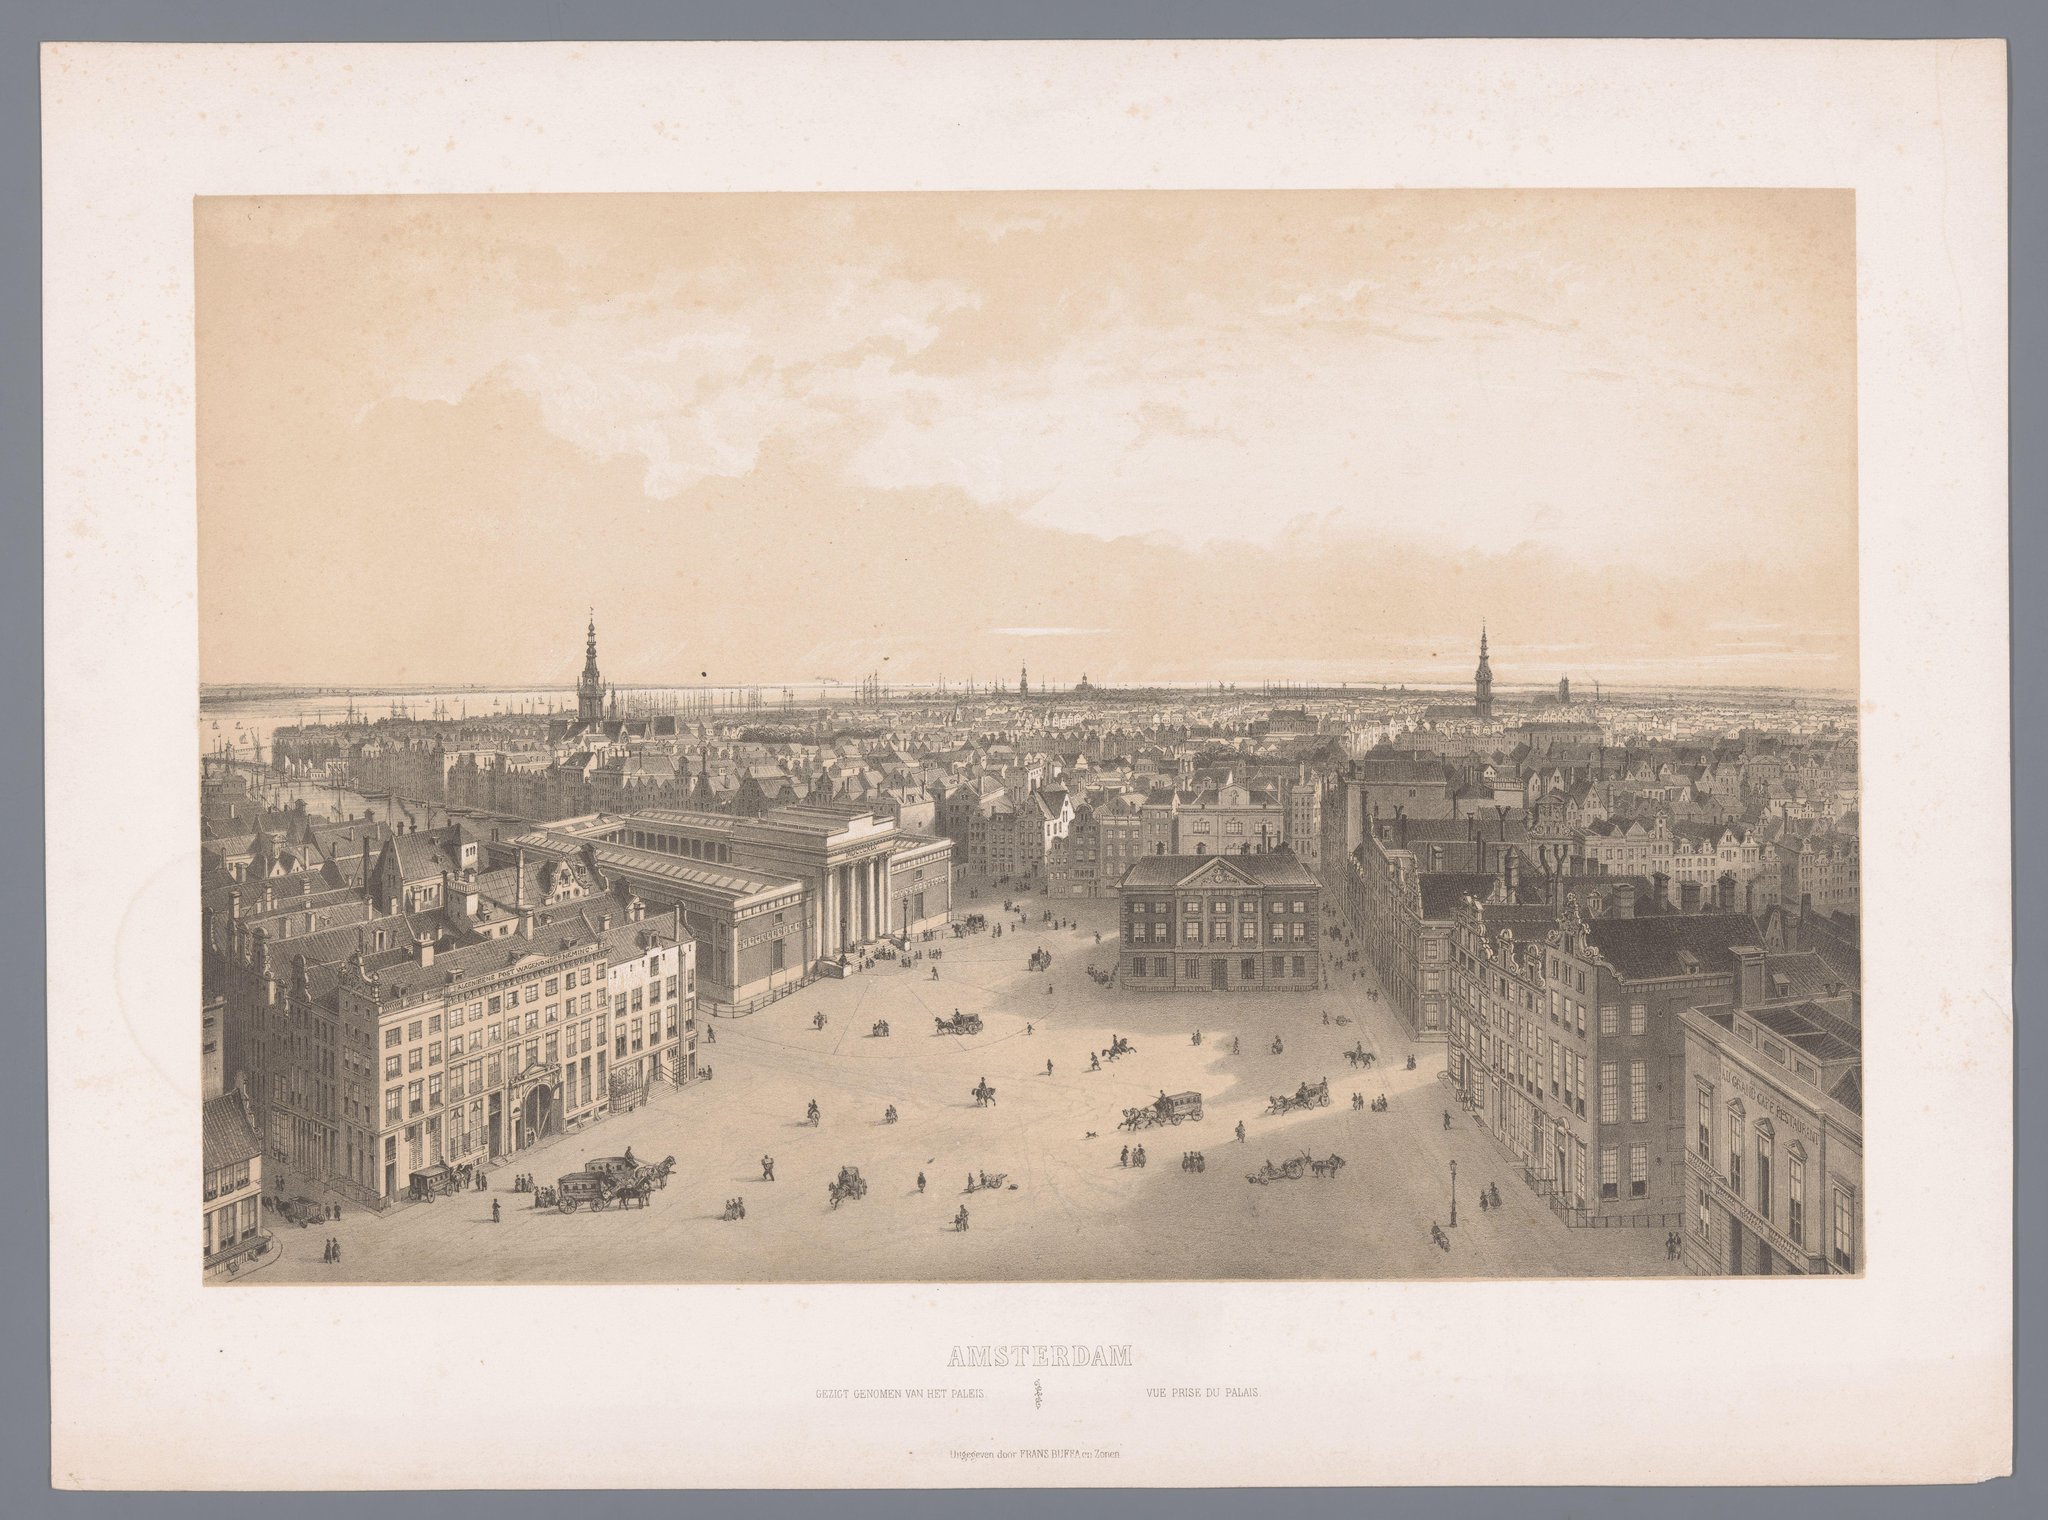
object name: print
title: Amsterdam gezigt genomen van het Paleis / Vue prise du Palais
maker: Anonymous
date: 1800-1899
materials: paper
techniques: tone lithography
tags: square, place, circus, etc.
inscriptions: collector's mark: Lugt 2228